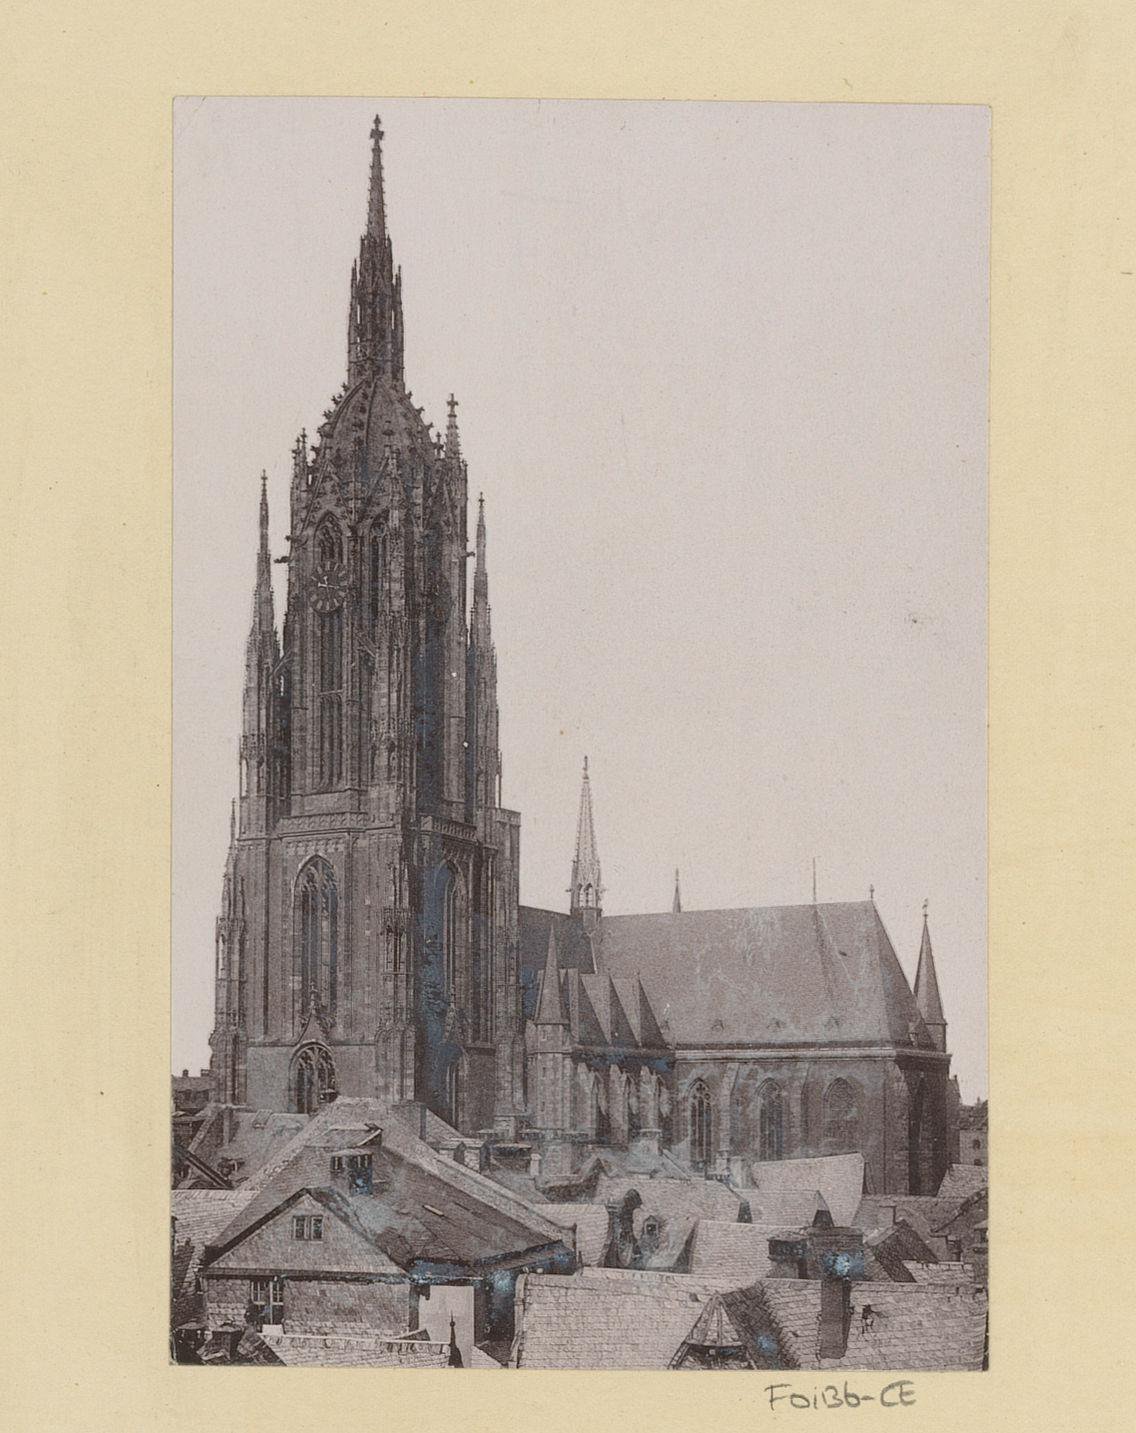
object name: photomechanical print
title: Dom van Frankfurt am Main, gezien over daken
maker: Anonymous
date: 1880-1895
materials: paper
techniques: photograph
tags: church (exterior), parts of church exterior and annexes: tower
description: Onderdeel van Fotoalbum met opnames van bezienswaardigheden in België, Duitsland en Noorwegen.